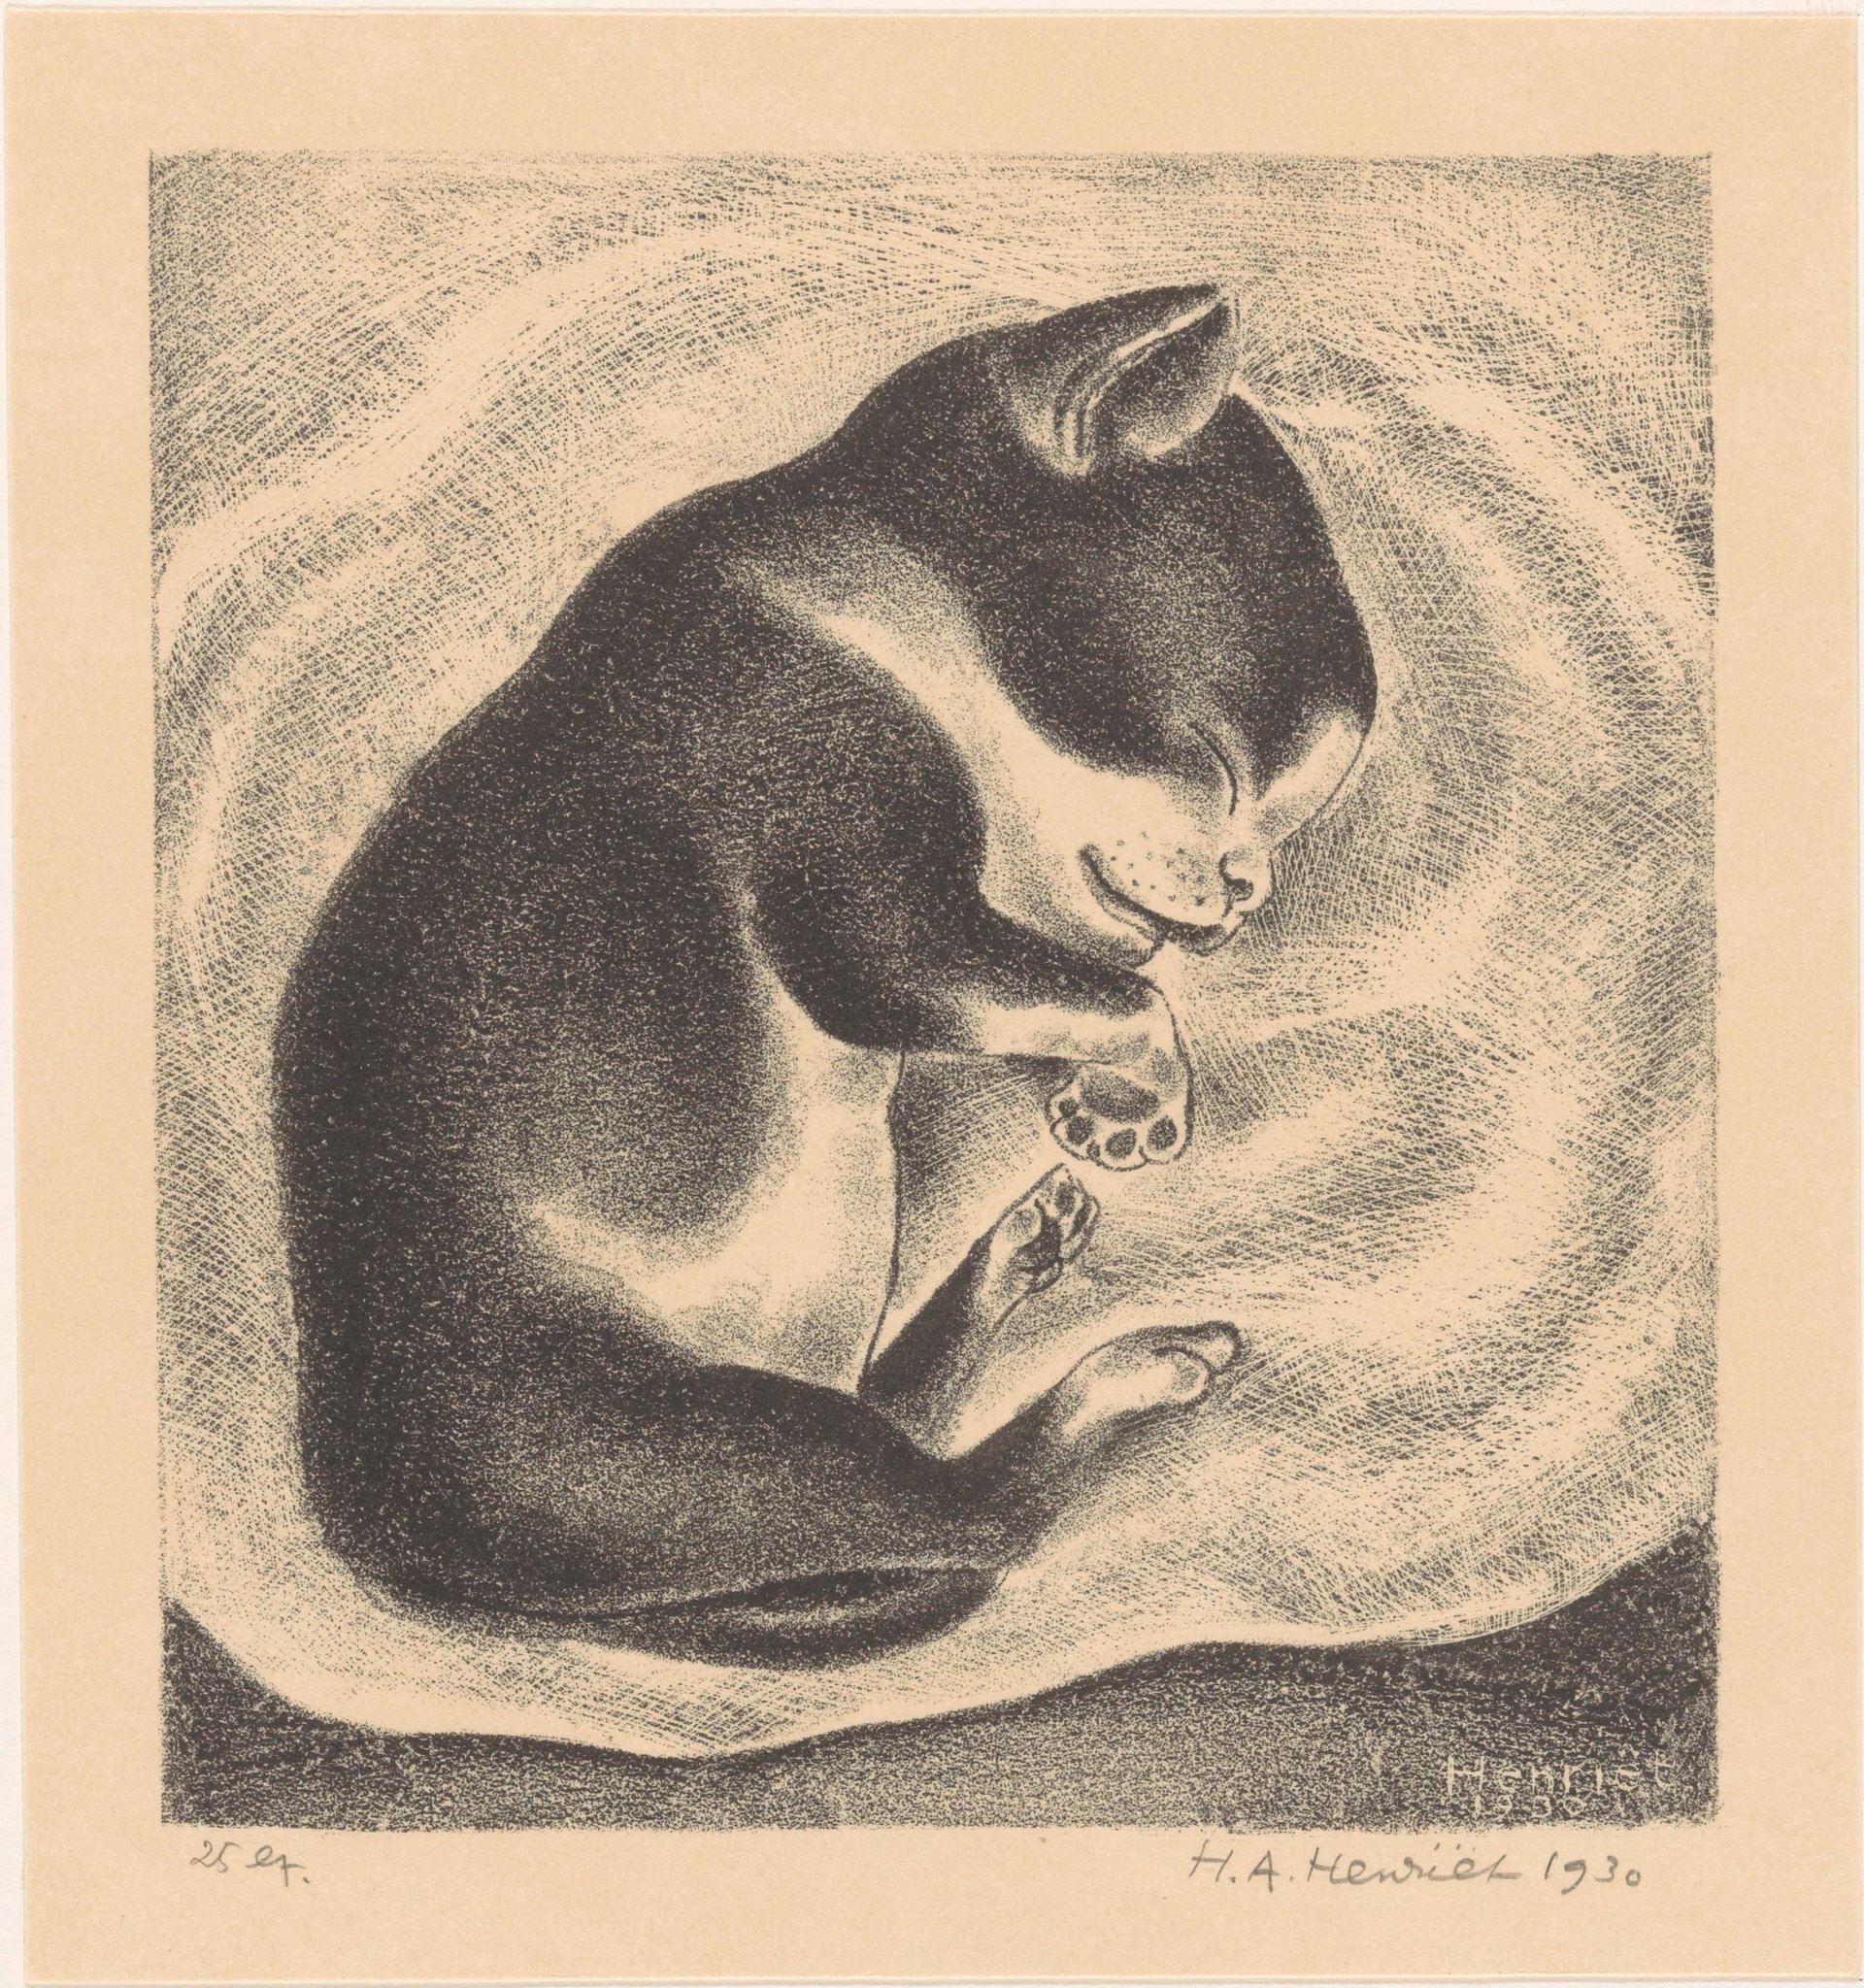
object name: print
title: Slapende, jonge kat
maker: henk henriët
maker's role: draughtsman, print maker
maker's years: 1903-1945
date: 1930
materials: paper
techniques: lithograph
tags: cat (+ young animal)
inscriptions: collector's mark: Lugt 2228